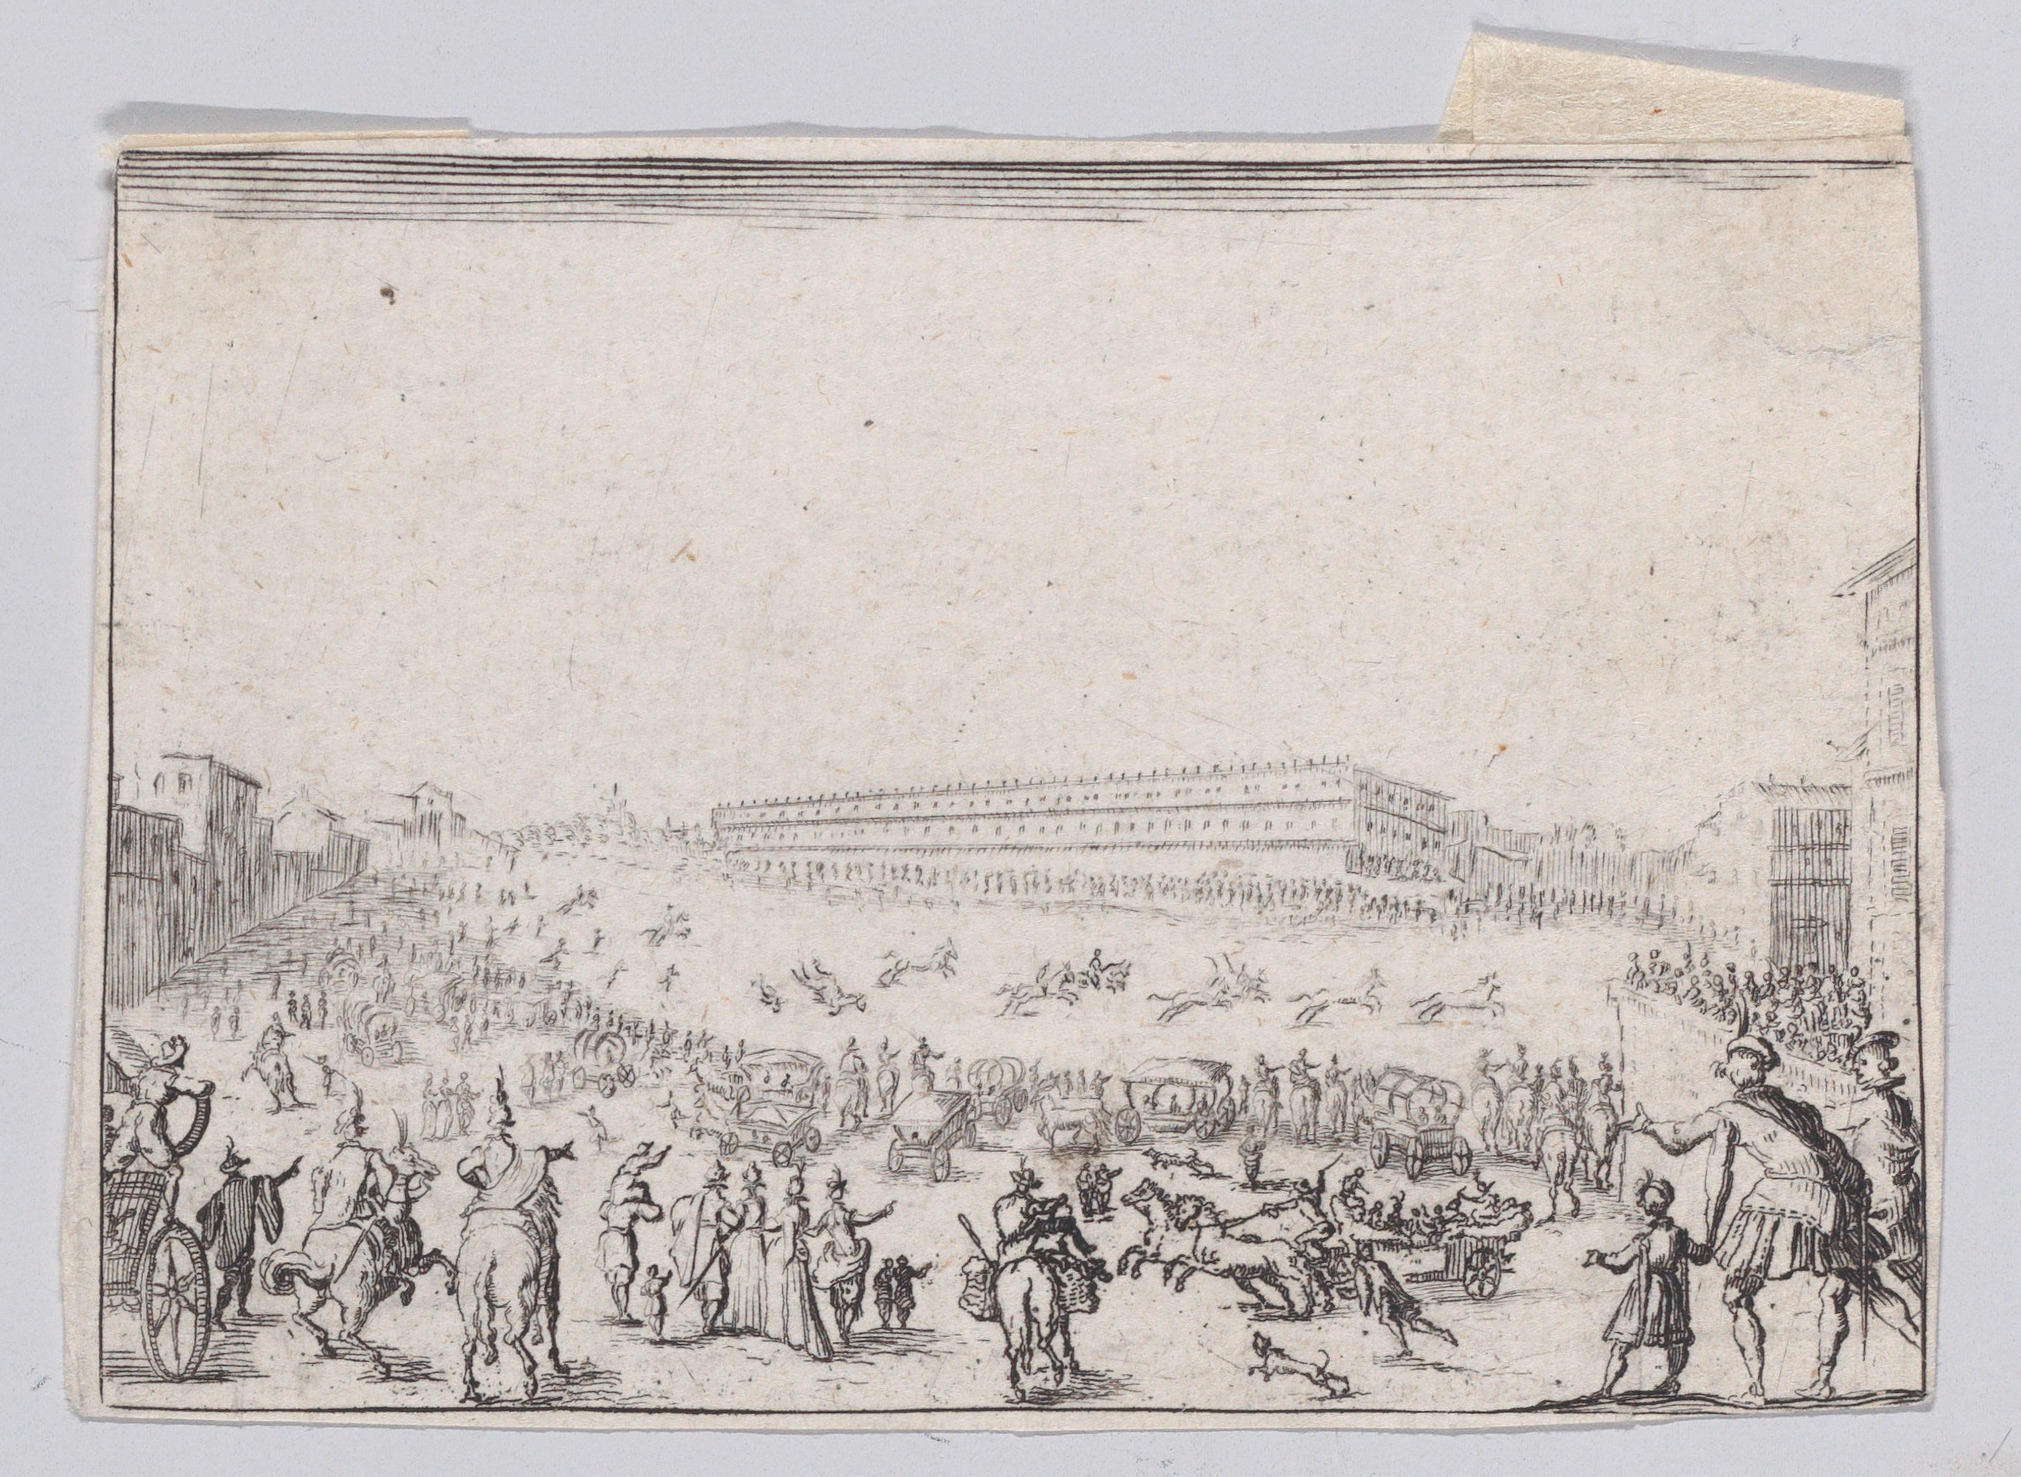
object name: print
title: Reverse Copy of La Course de Chevaux sur la Place Pitti a Florence (The Horse Race at the Piazza Pitti in Florence), from "Les Caprices", Series A, The Florence Set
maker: Anonymous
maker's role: artist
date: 1601-1700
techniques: etching